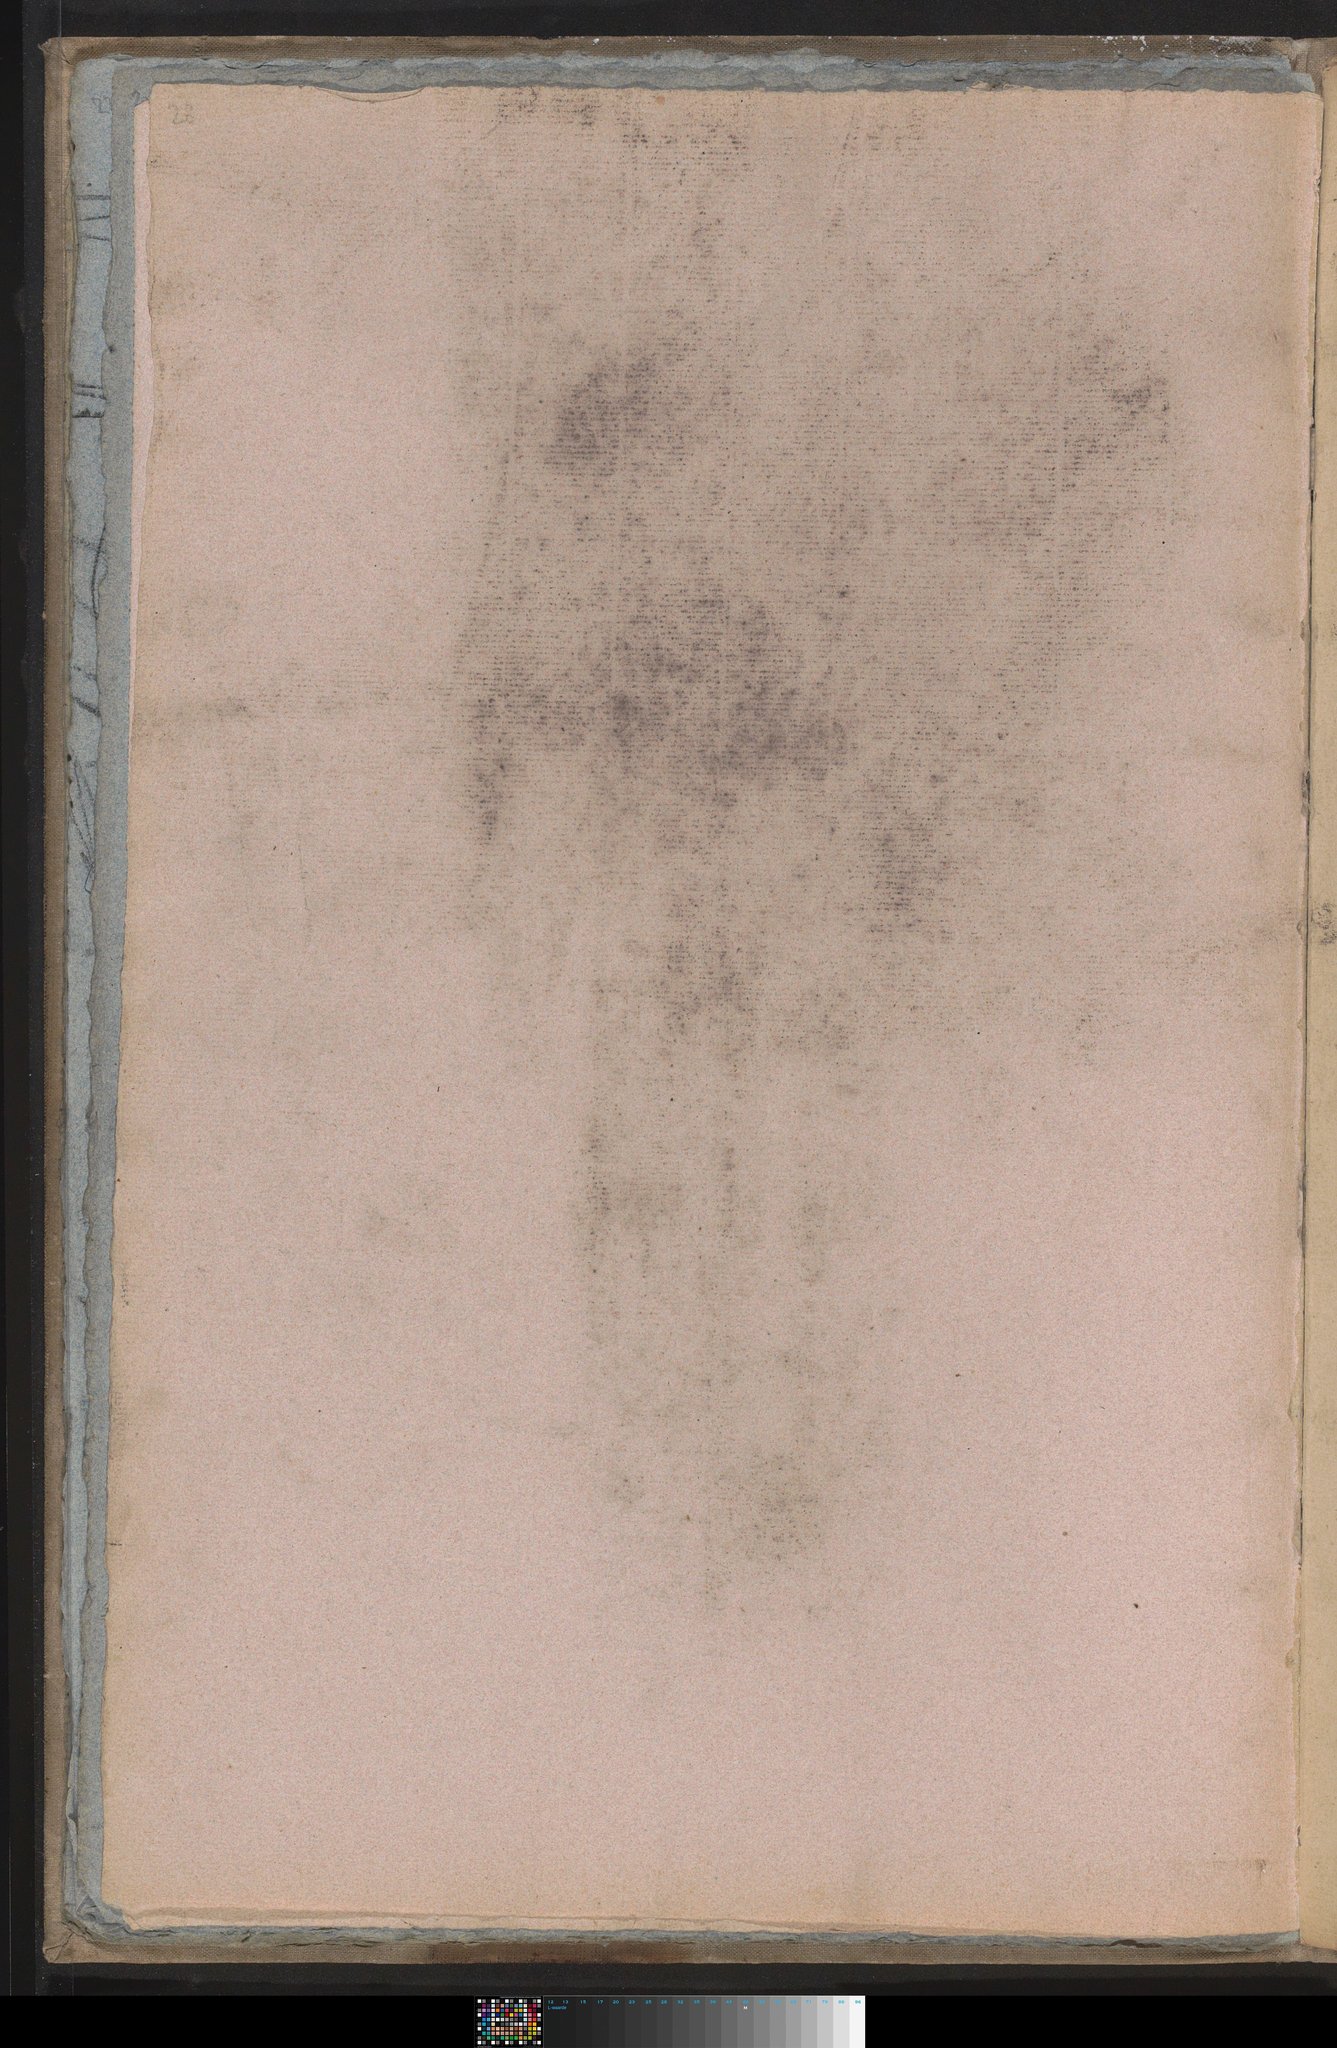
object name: sketchbook leaf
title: Abklatsch van de krijttekening op pagina 29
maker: willem witsen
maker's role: draughtsman, painter, print maker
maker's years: 1860-1923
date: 1884-1887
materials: paper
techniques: printmaking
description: Pagina 28 uit een schetsboek met 45 bladen vervaardigd rond de Ewijkshoeve.